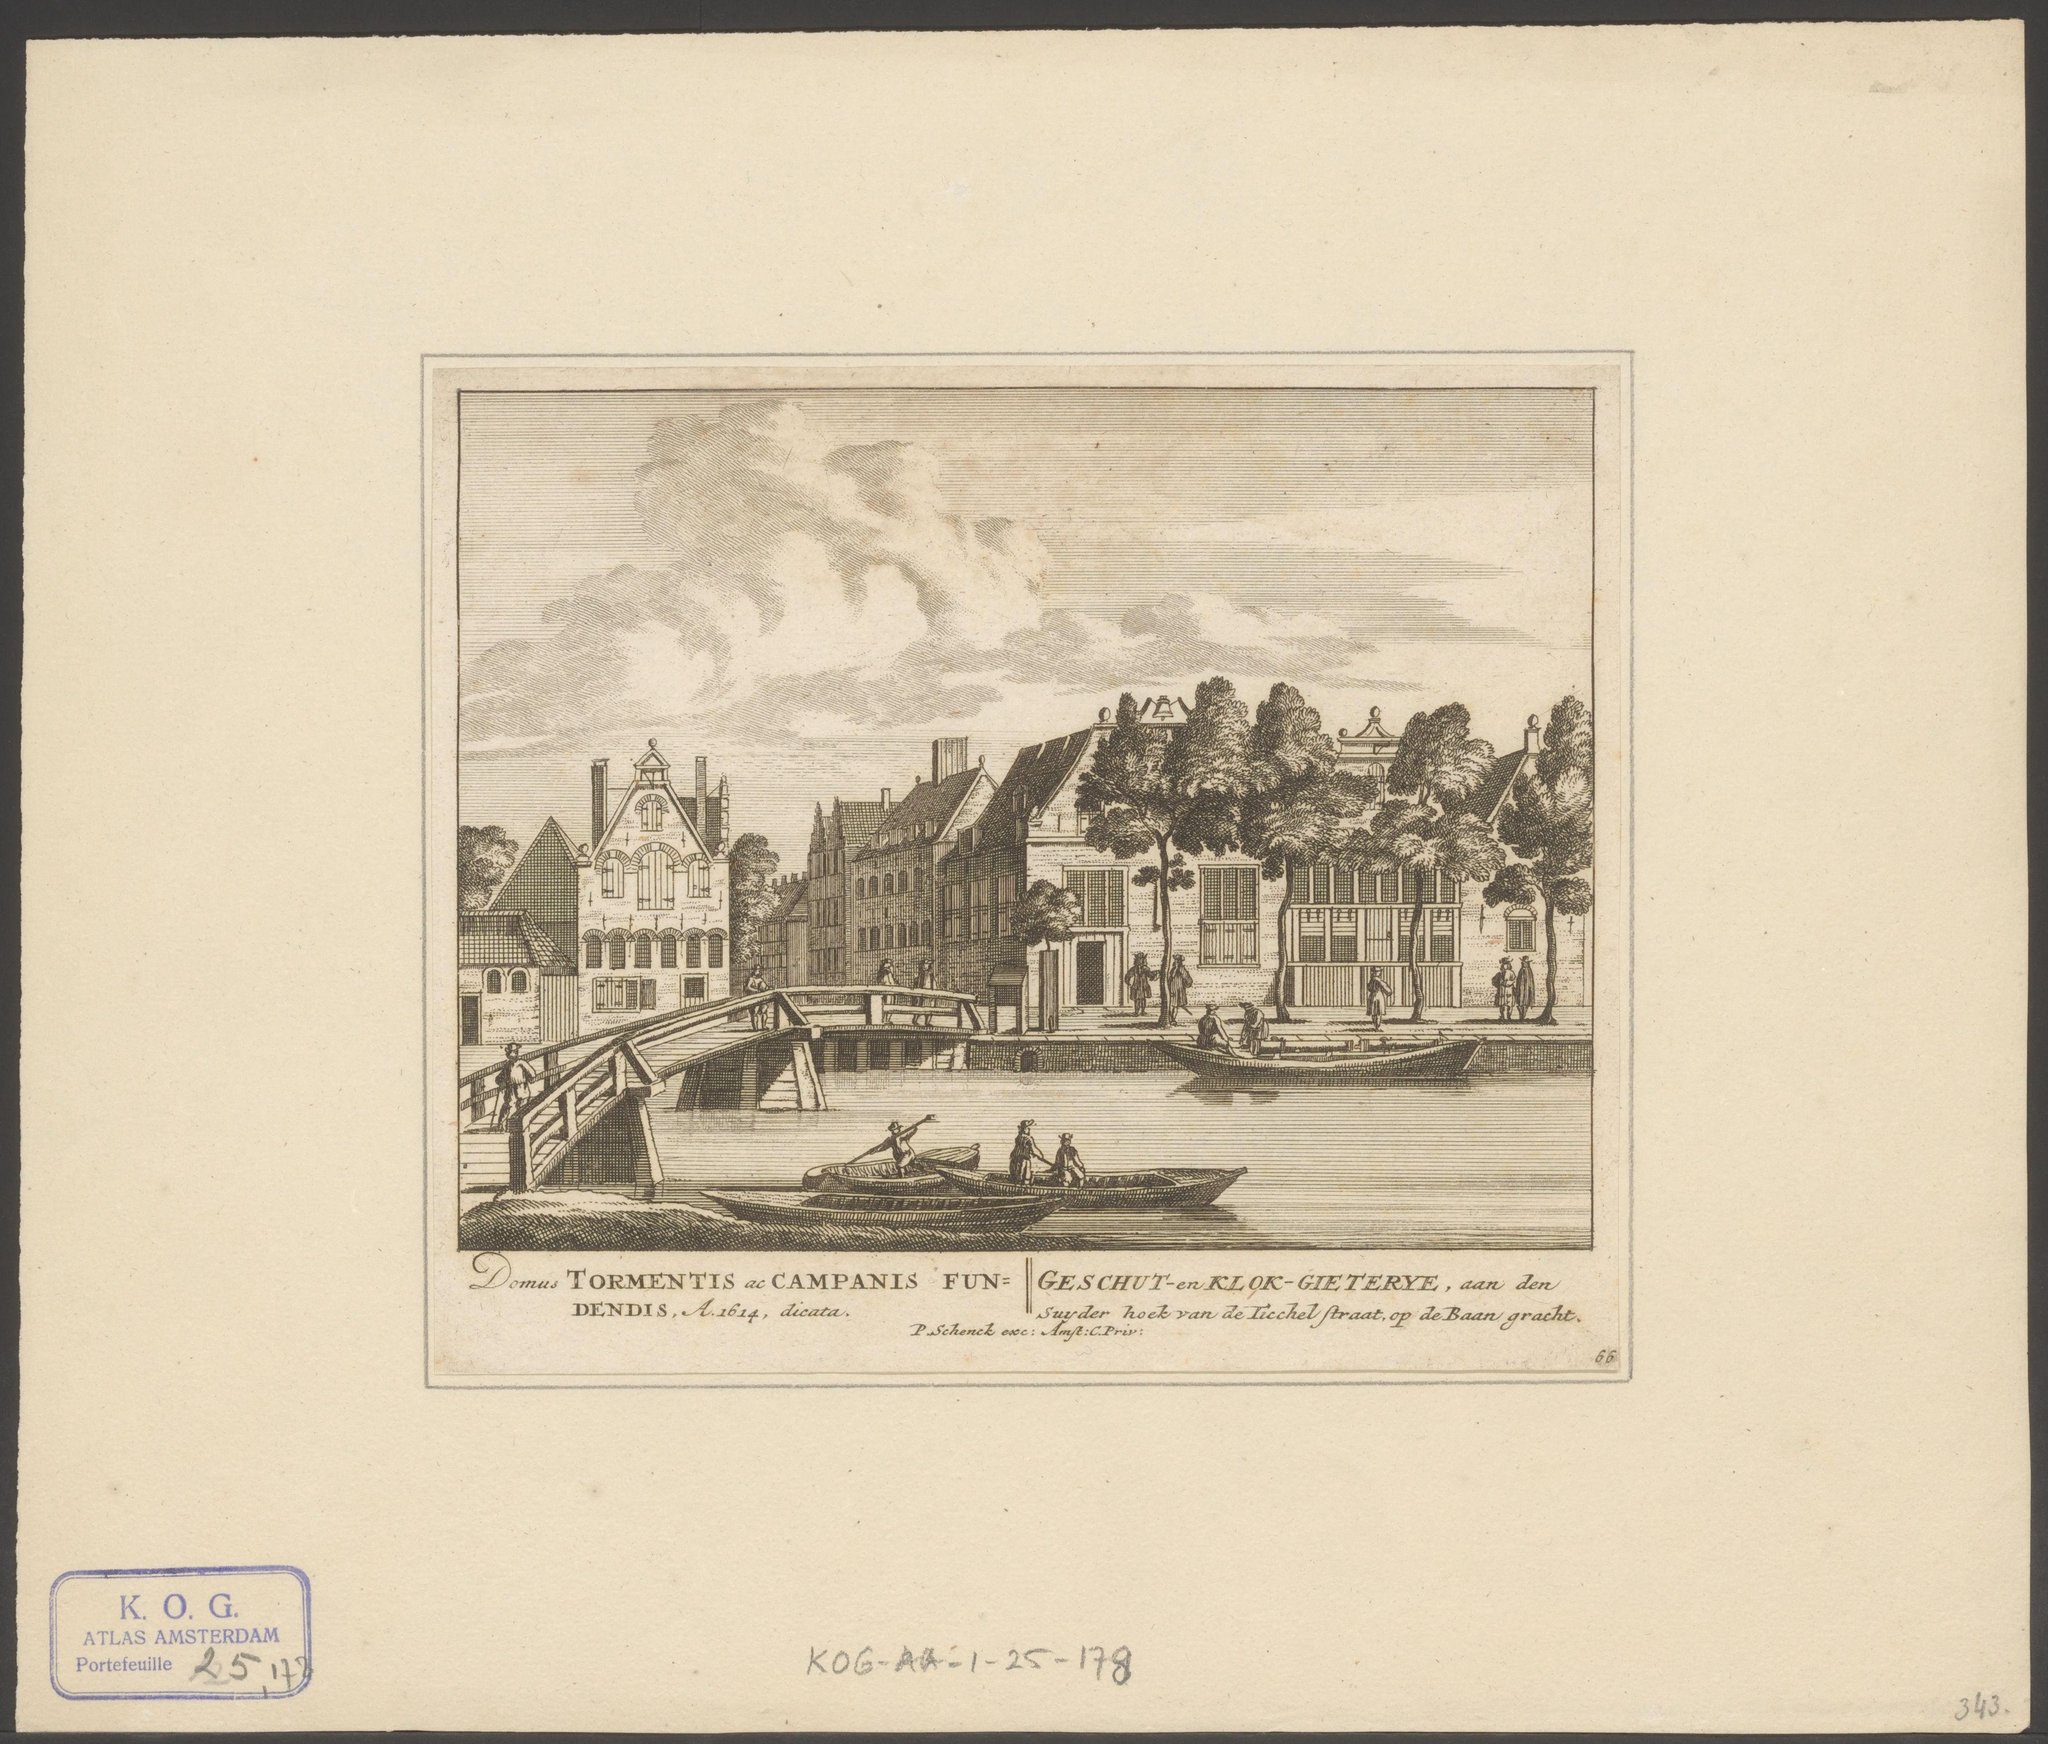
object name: book illustration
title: 100 Afbeeldinge der voornaamste gebouwen van Amsterdam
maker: Anonymous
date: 1710-1711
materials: paper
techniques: engraving, etching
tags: bell-founder, factory-building, canals, waters (in city) (+ city(-scape) with figures, staffage), street (+ city(-scape) with figures, staffage)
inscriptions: collector's mark: Lugt 1641b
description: Rechtsonder genummerd: 66. Onderwerpsrubriek binnen de Atlas Amsterdam: Krijgswezen I: De Admiraliteit van Amsterdam, F. Magazijnen, Geschutsgieterij, Artillerieën, Korenhuizen.